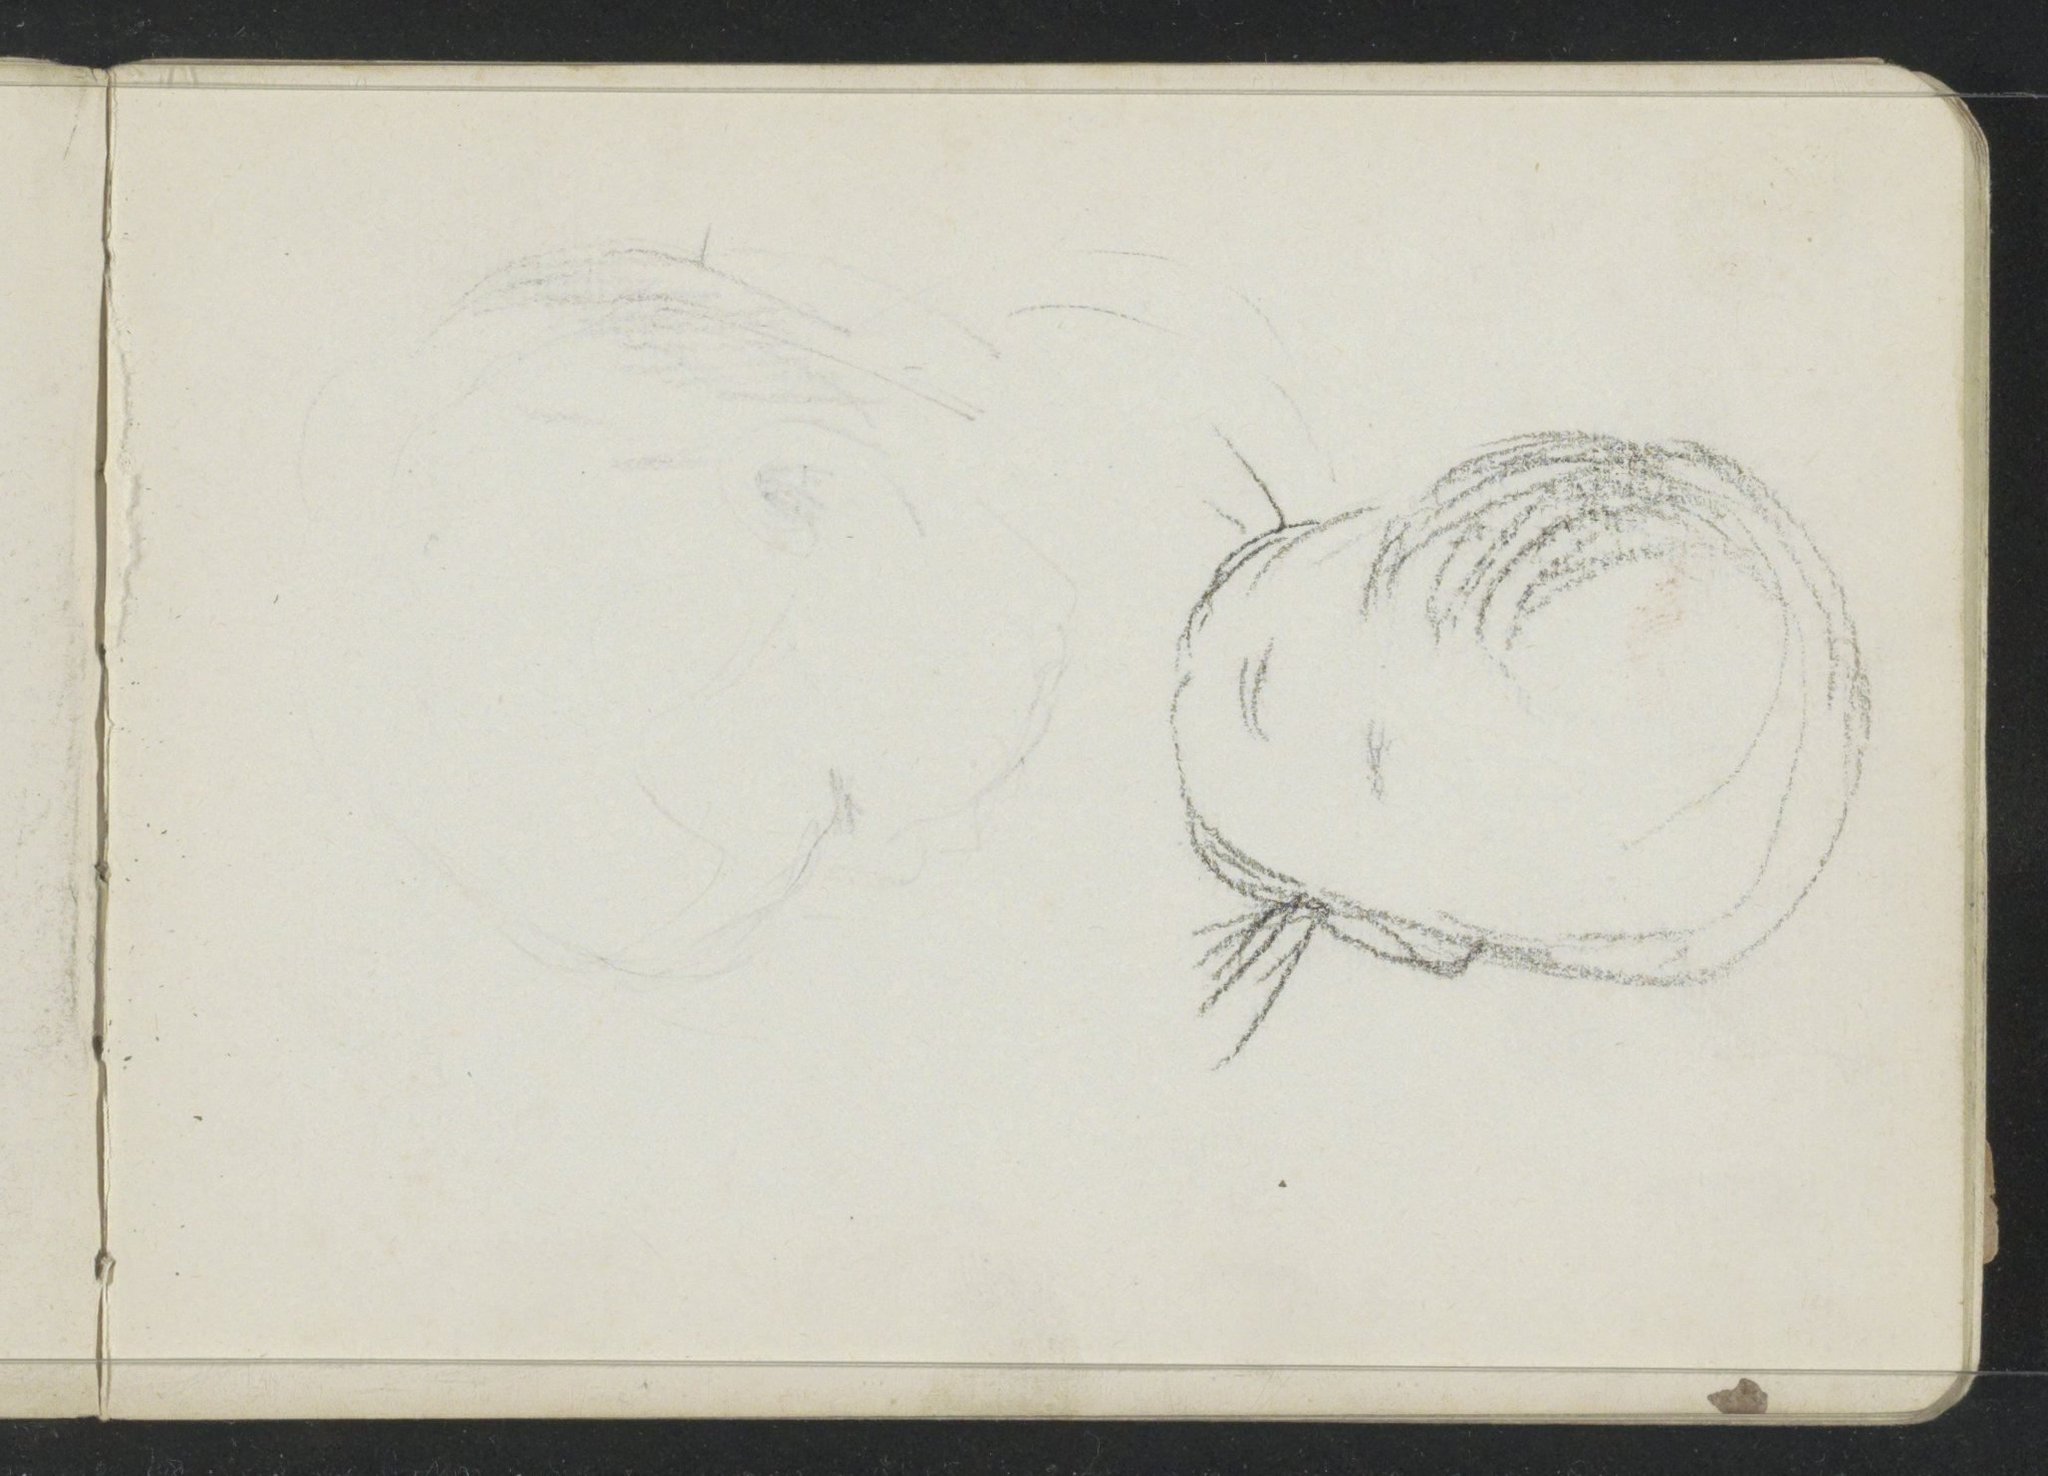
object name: sketchbook leaf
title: Hoofd van een kind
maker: johanna van de kamer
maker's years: 1873-1922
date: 1883-1922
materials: chalk, paper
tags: head (human), child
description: Blad 8 recto uit een schetsboek met 27 bladen.